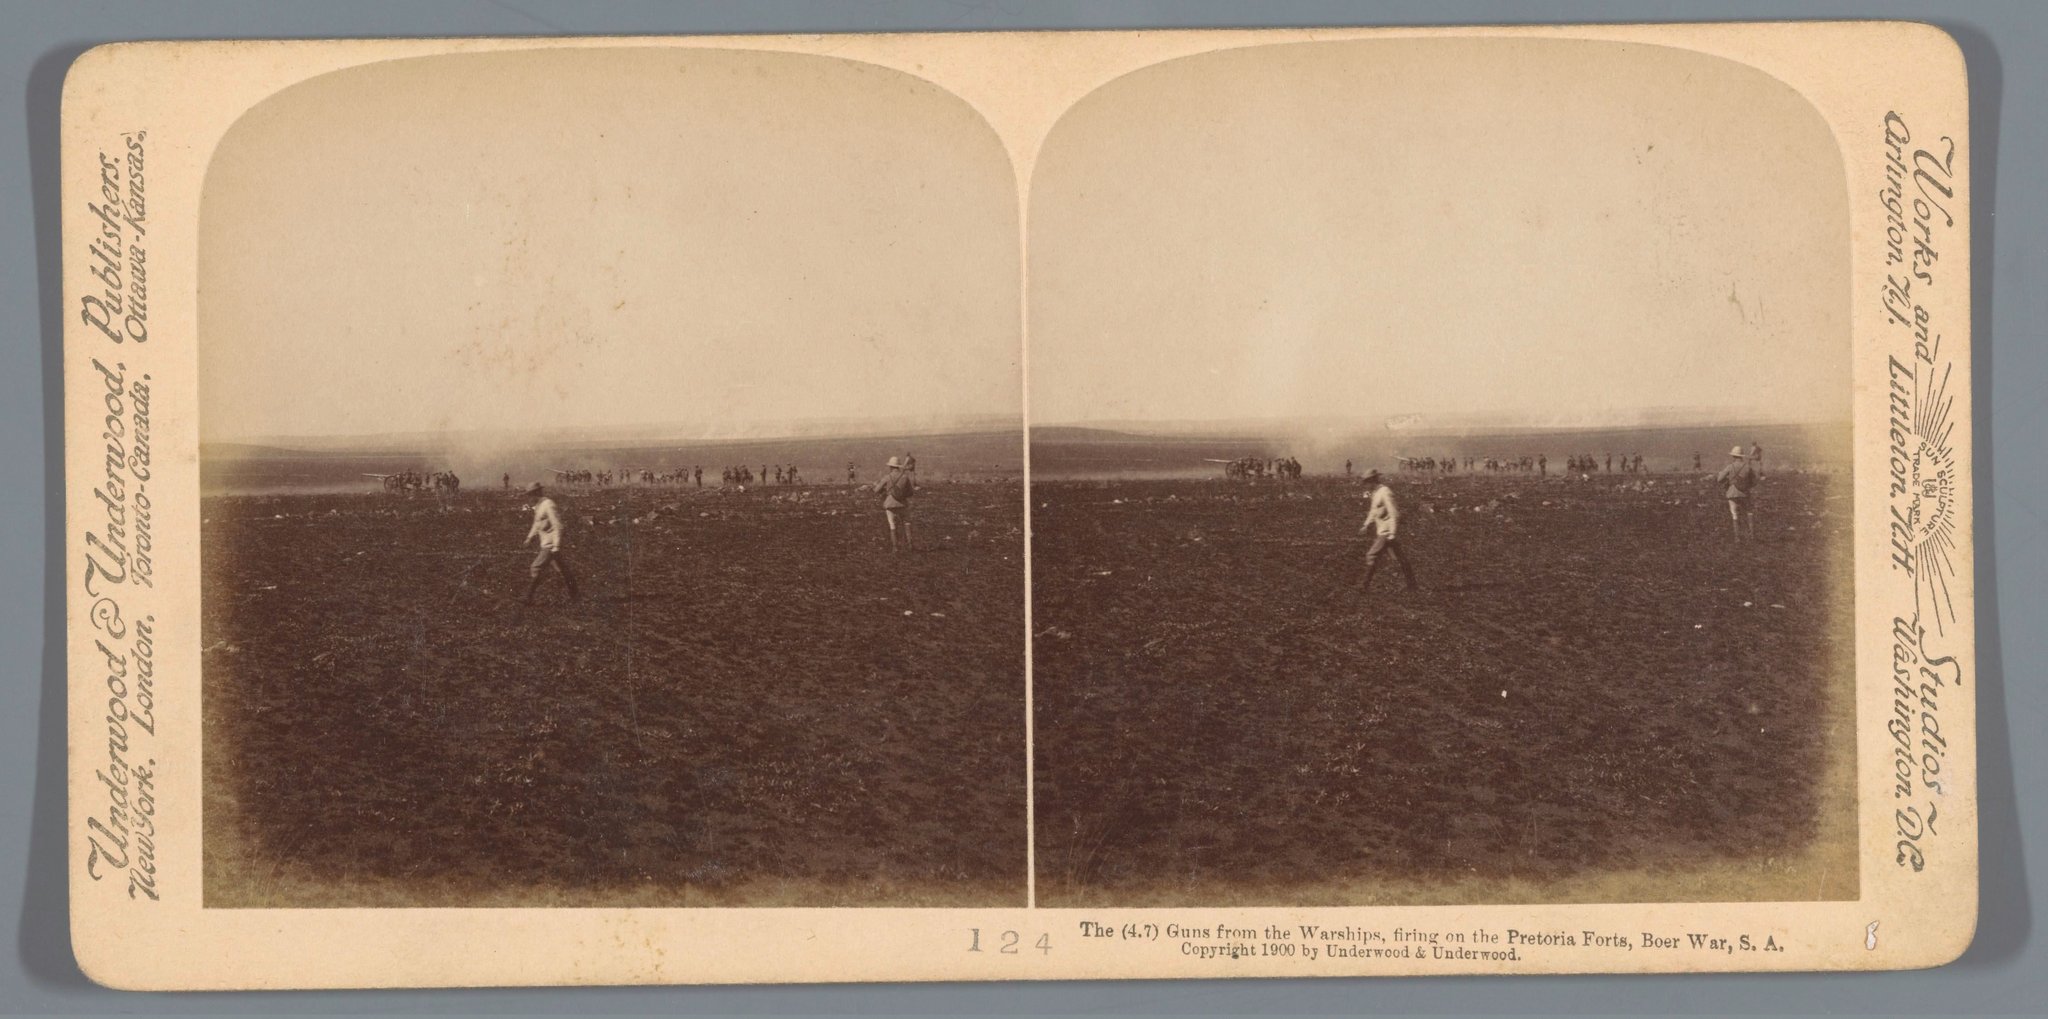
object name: stereograph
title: Gezicht op een aanval op forten in Pretoria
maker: Anonymous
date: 1900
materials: cardboard, paper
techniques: albumen print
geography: pretoria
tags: firearms, siege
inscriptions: inscription: ‘Works and Studios ~/ Arlington, N.J. Littleton, N.H. Washington, D.C.’, copyright notice: ‘Copyright 1900 by Underwood & Underwood.’, inscription, number: ‘124’